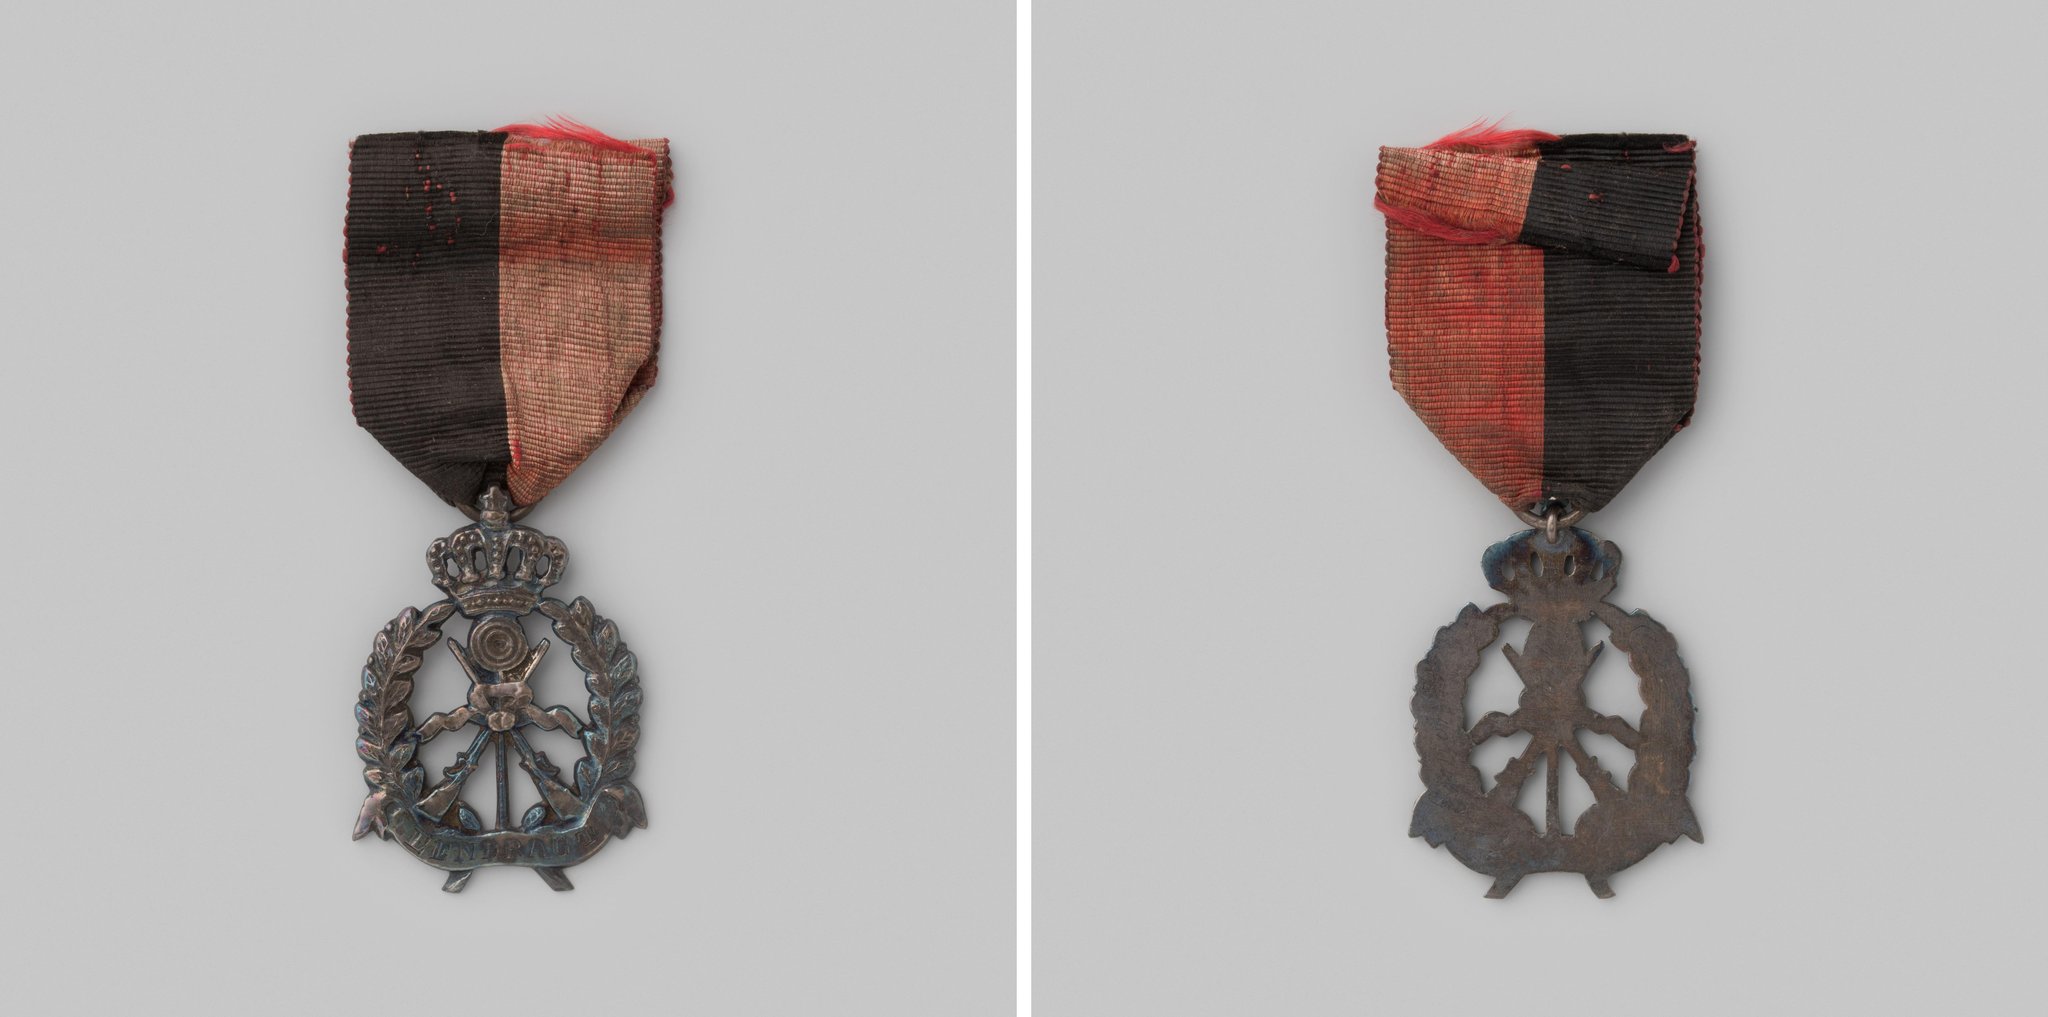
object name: insignia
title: Draagteken van de vereniging Eendragt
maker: Anonymous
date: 1858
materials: silver, textile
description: Zilveren draagpenning met oog, ring en lint.